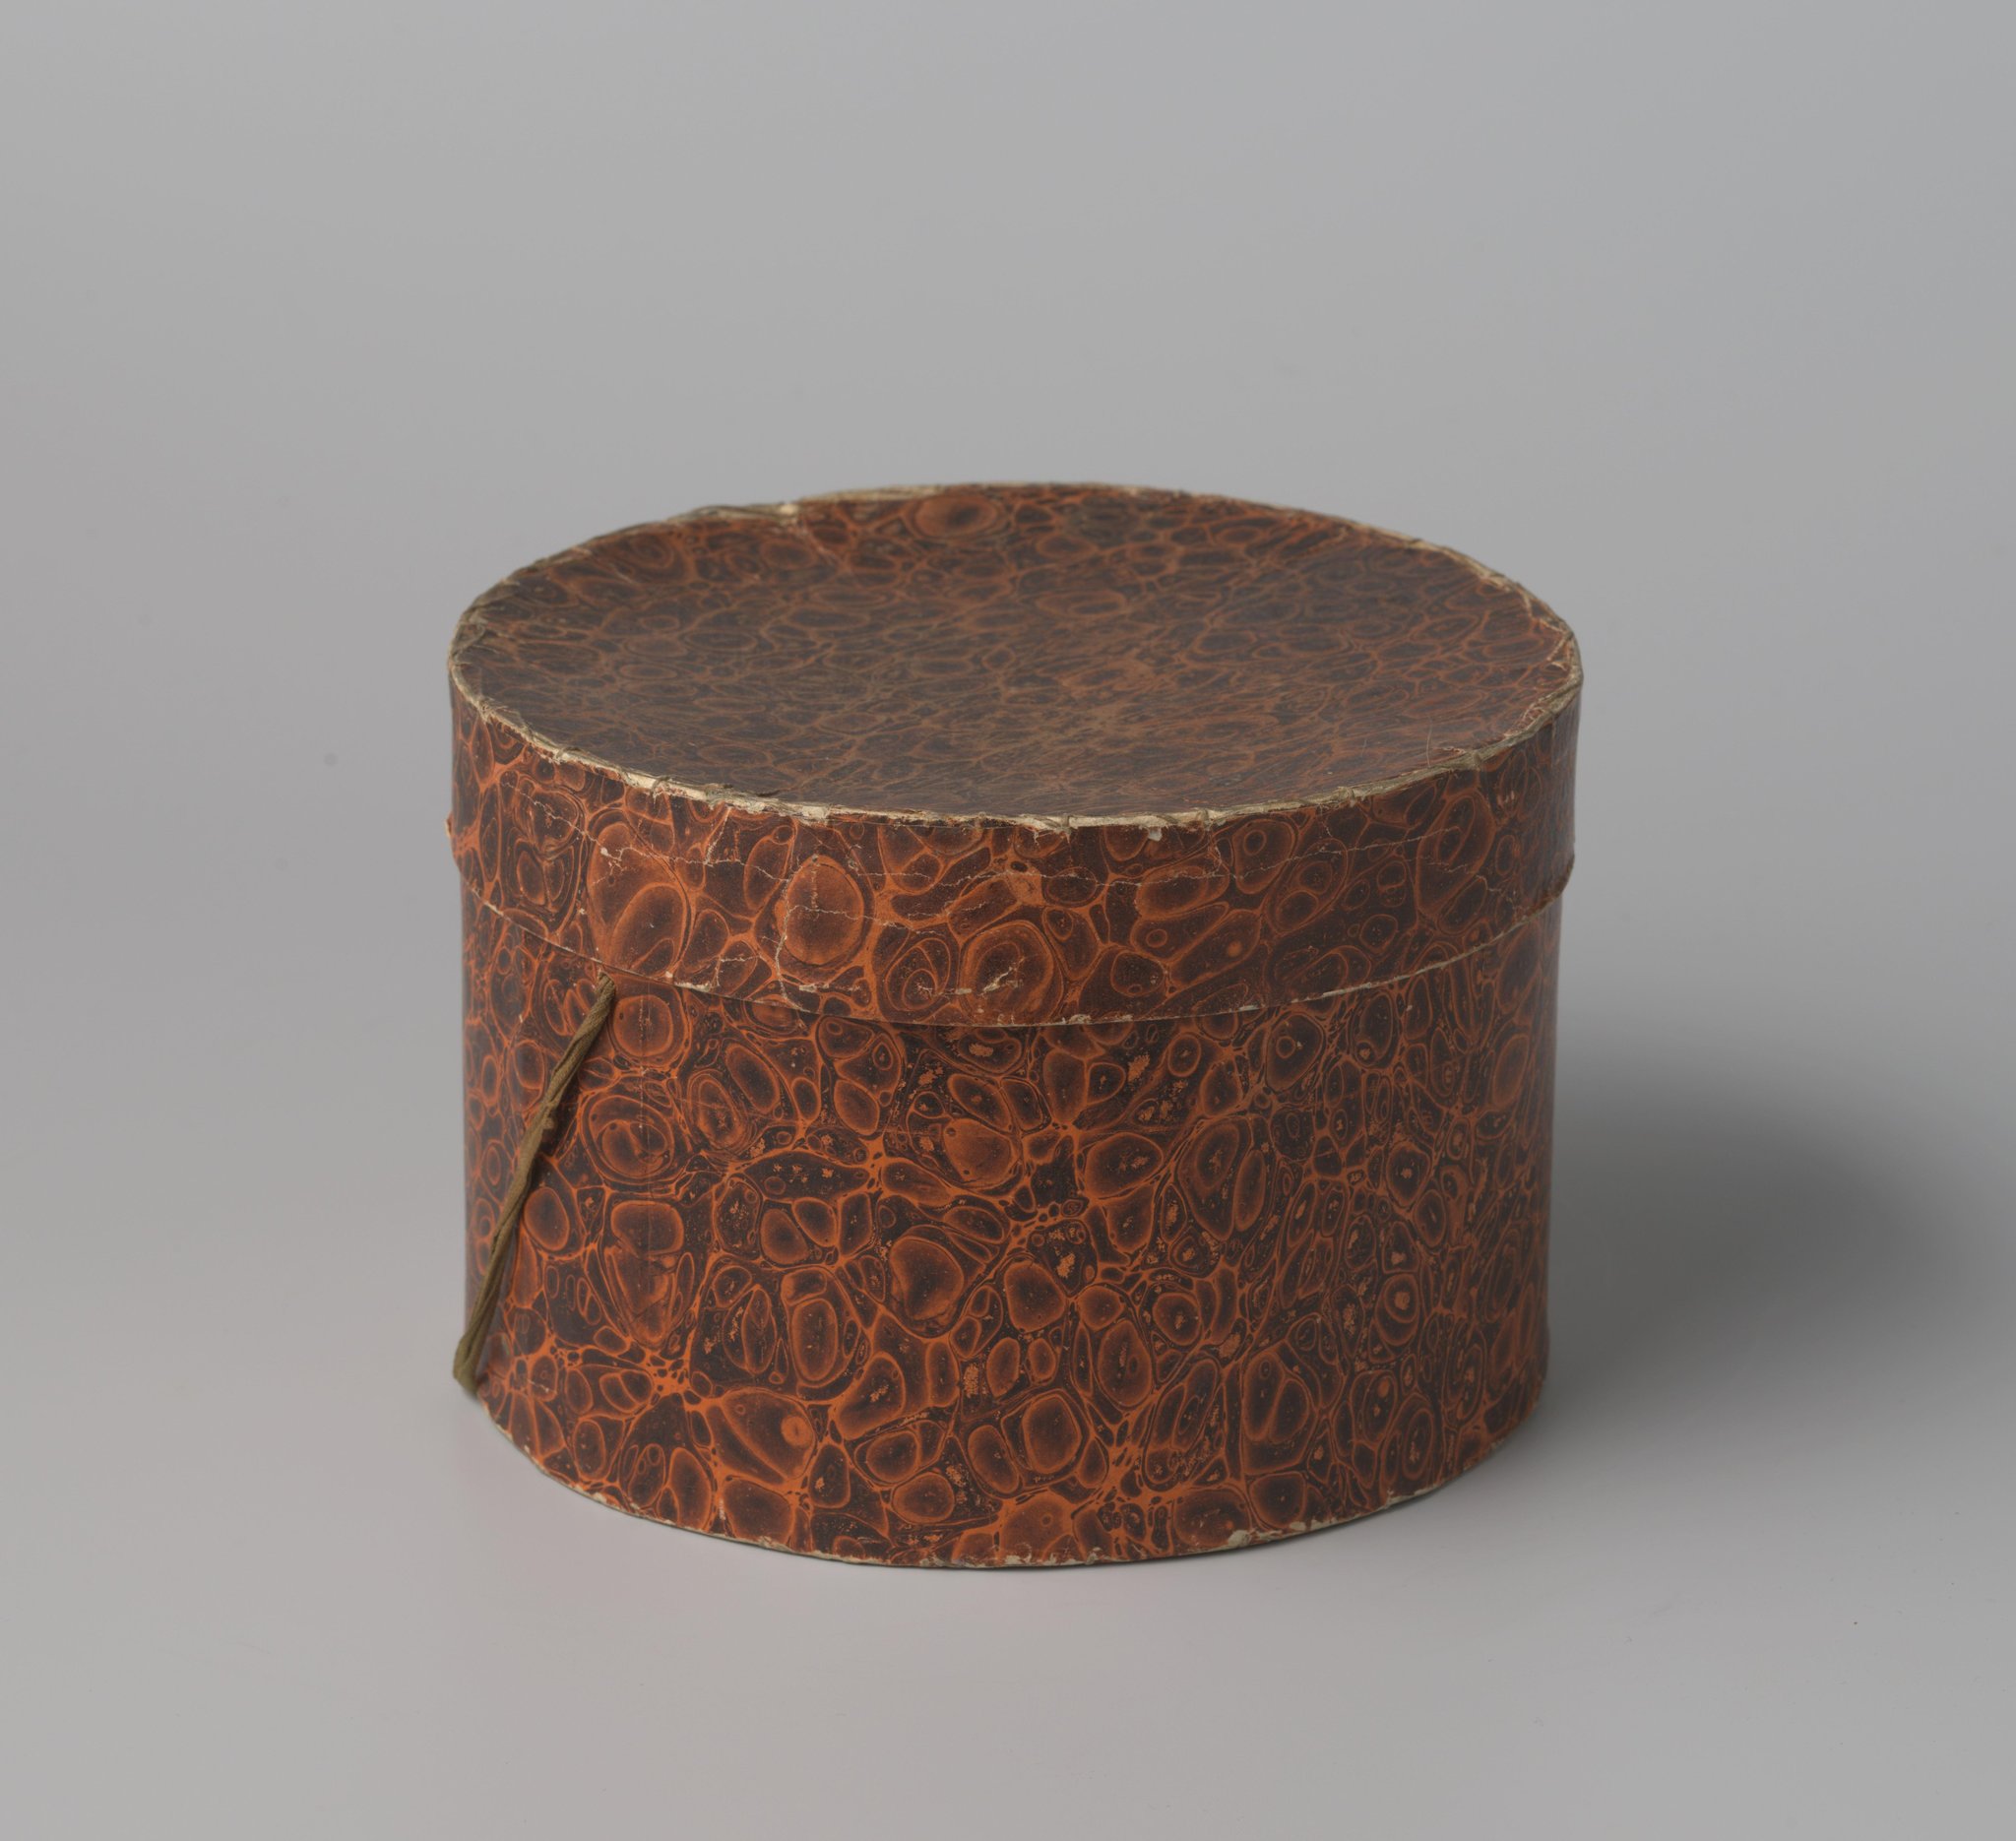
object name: hat box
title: Ronde hoedendoos van karton, beplakt met roestbruin gemarmerd papier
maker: Anonymous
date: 1830-1840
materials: cardboard, linen, paper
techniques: pasting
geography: netherlands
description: Ronde hoedendoos van karton, beplakt met roestbruin gemarmerd papier. De doos is van binnen beplakt met blauw papier. Met een groen striklint als handvat. Behoort bij twee poppenluifelhoeden (BK-1983-68-A/B).